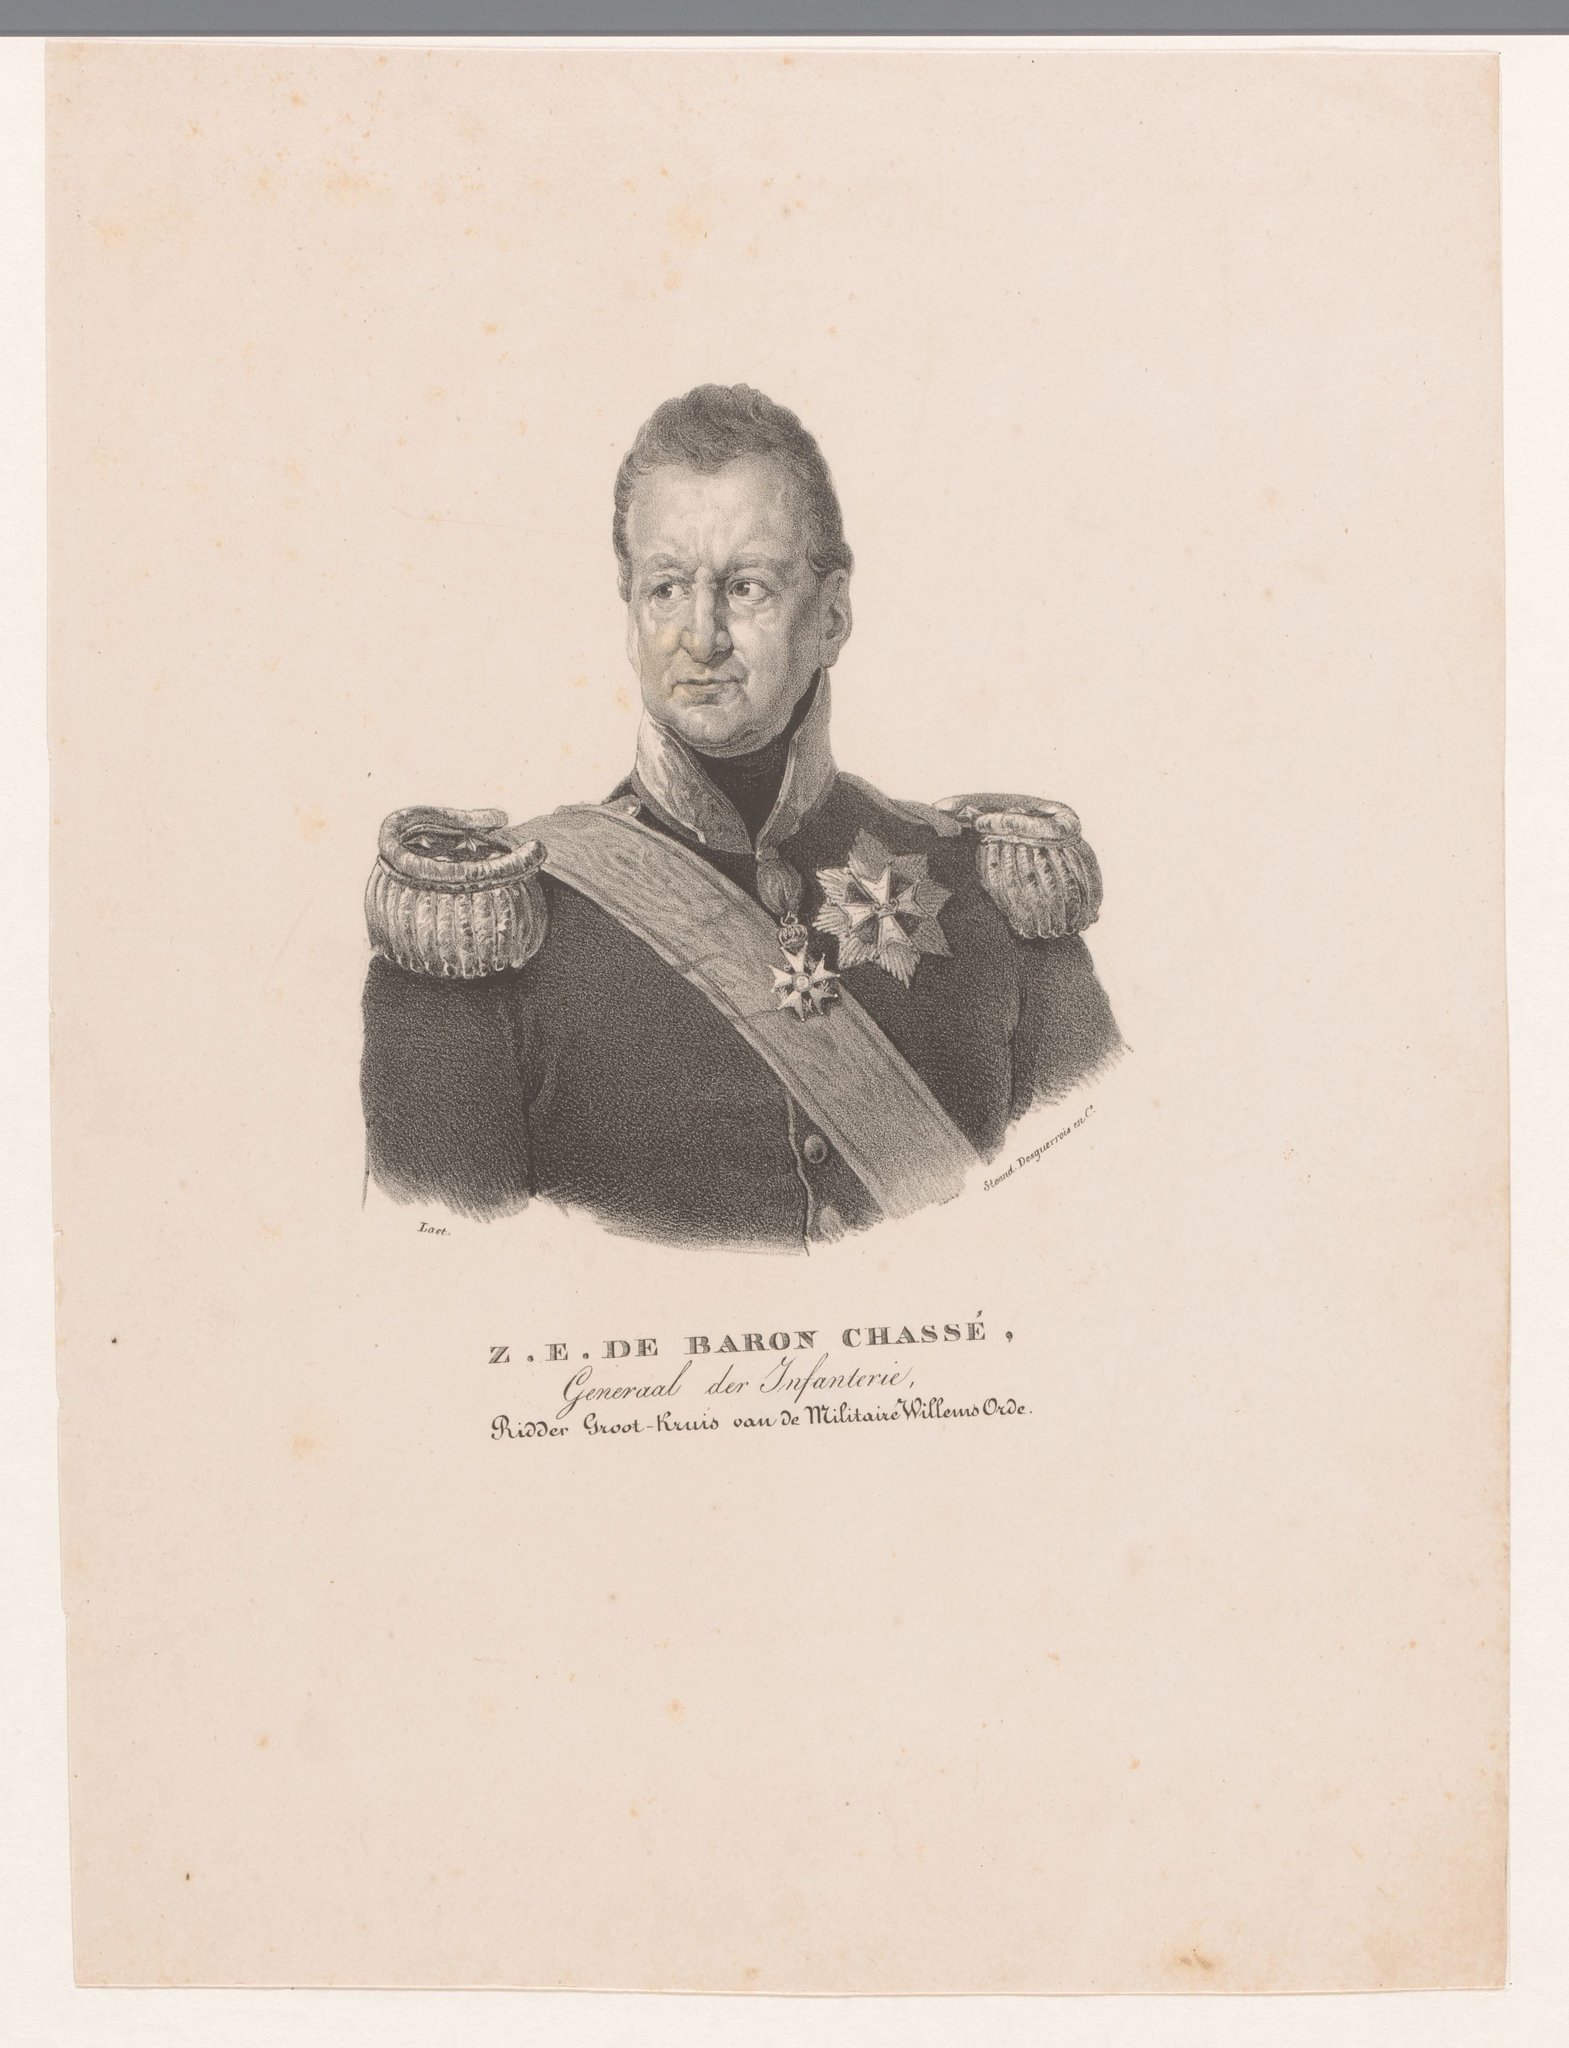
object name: print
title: Portret van David Hendrik baron Chassé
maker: carel christiaan antony last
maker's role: print maker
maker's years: 1808-1876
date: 1818-1876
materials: paper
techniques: lithograph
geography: netherlands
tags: david hendrik baron chassé, knighthood order, historical persons (+ (full) bust portrait)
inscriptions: collector's mark: Lugt 2228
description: De geportretteerde kijkt naar links, draagt een sjerp en twee ridderorden. Onder het portret zijn naam, beroep en onderscheidingen.